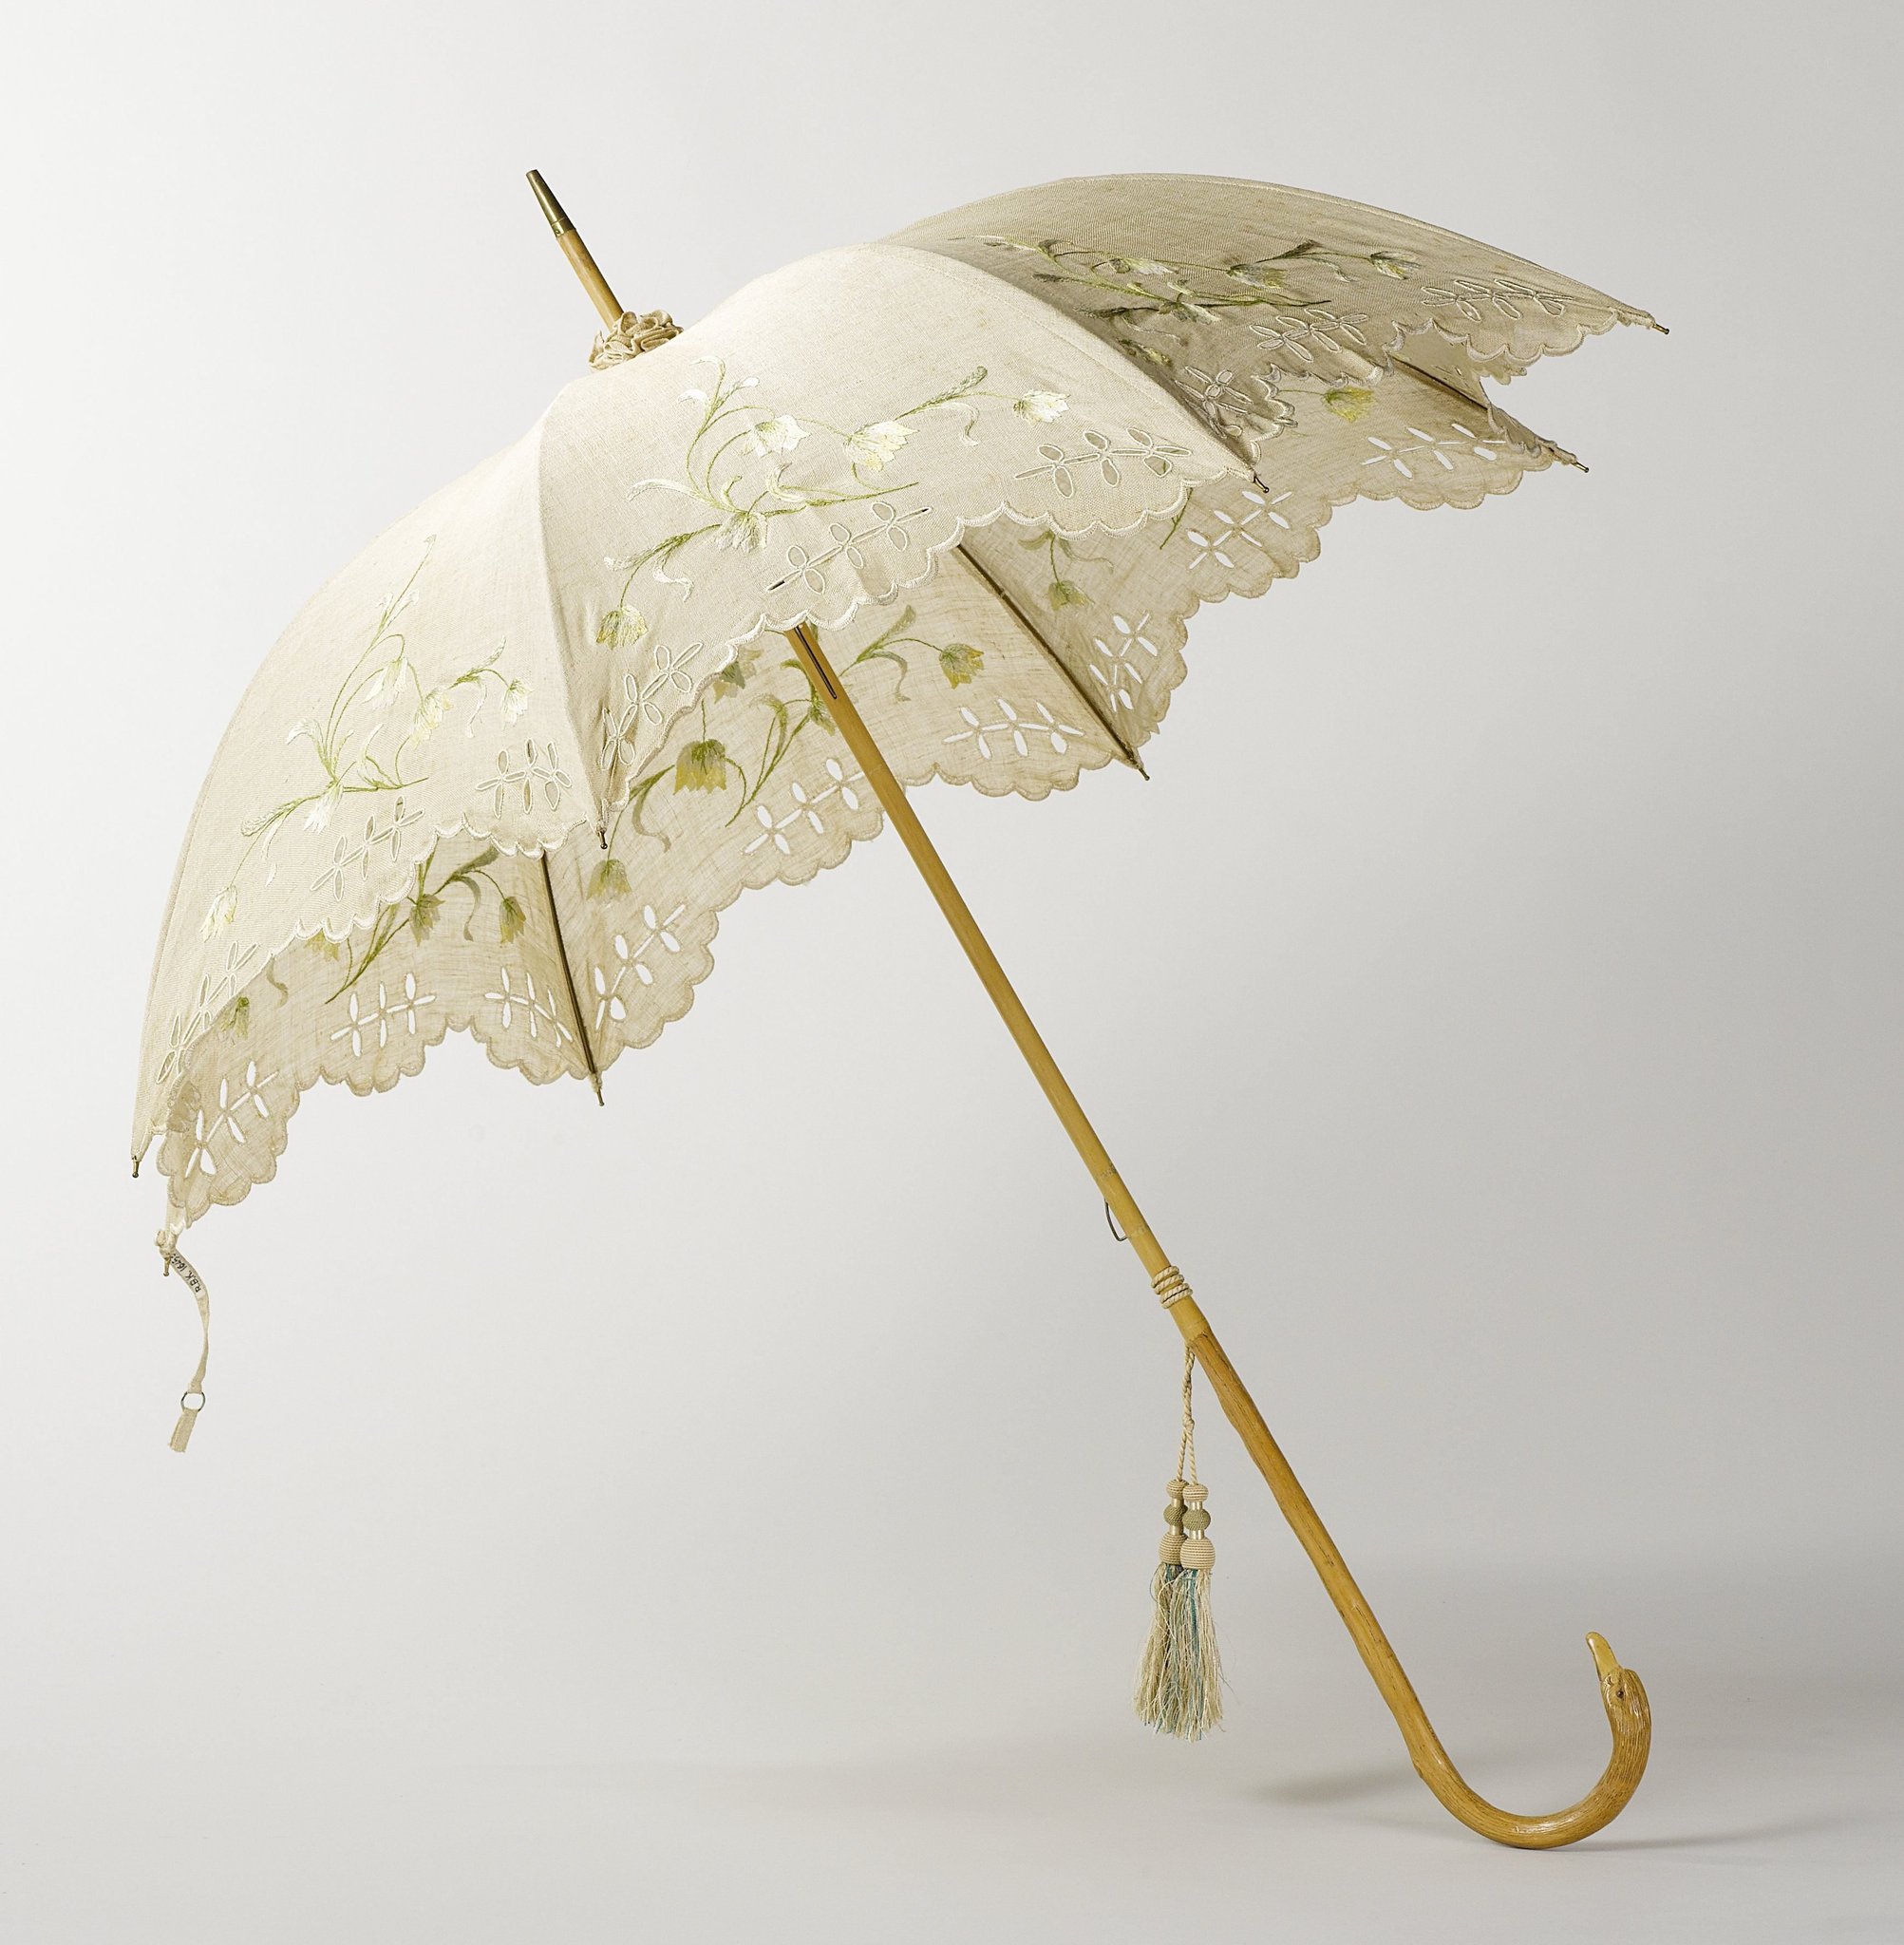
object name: parasol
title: Parasol met dek van écrukleurig linnen met borduurwerk op een stok van licht hout met knop in de vorm van een vogelkop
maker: Anonymous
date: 1905-1910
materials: linen, silk, wood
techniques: braiding, cutting, embroidered, weave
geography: netherlands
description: Parasol met een dek van écrukleurig linnen met borduurwerk. De stof heeft een geschulpte rand met koordzijden gecordonneerde kleinere schulpen en Henri-II-werk. Op iedere sector is van vloszijde een los gearrangeerd boeket van tulpen geborduurd. Ongevoerd, acht baleinen. Op een licht houten stok met omgebogen uiteinde in de vorm van een vogelkop. Een koord hangt aan de stok met twee kwasten in beige en groen.